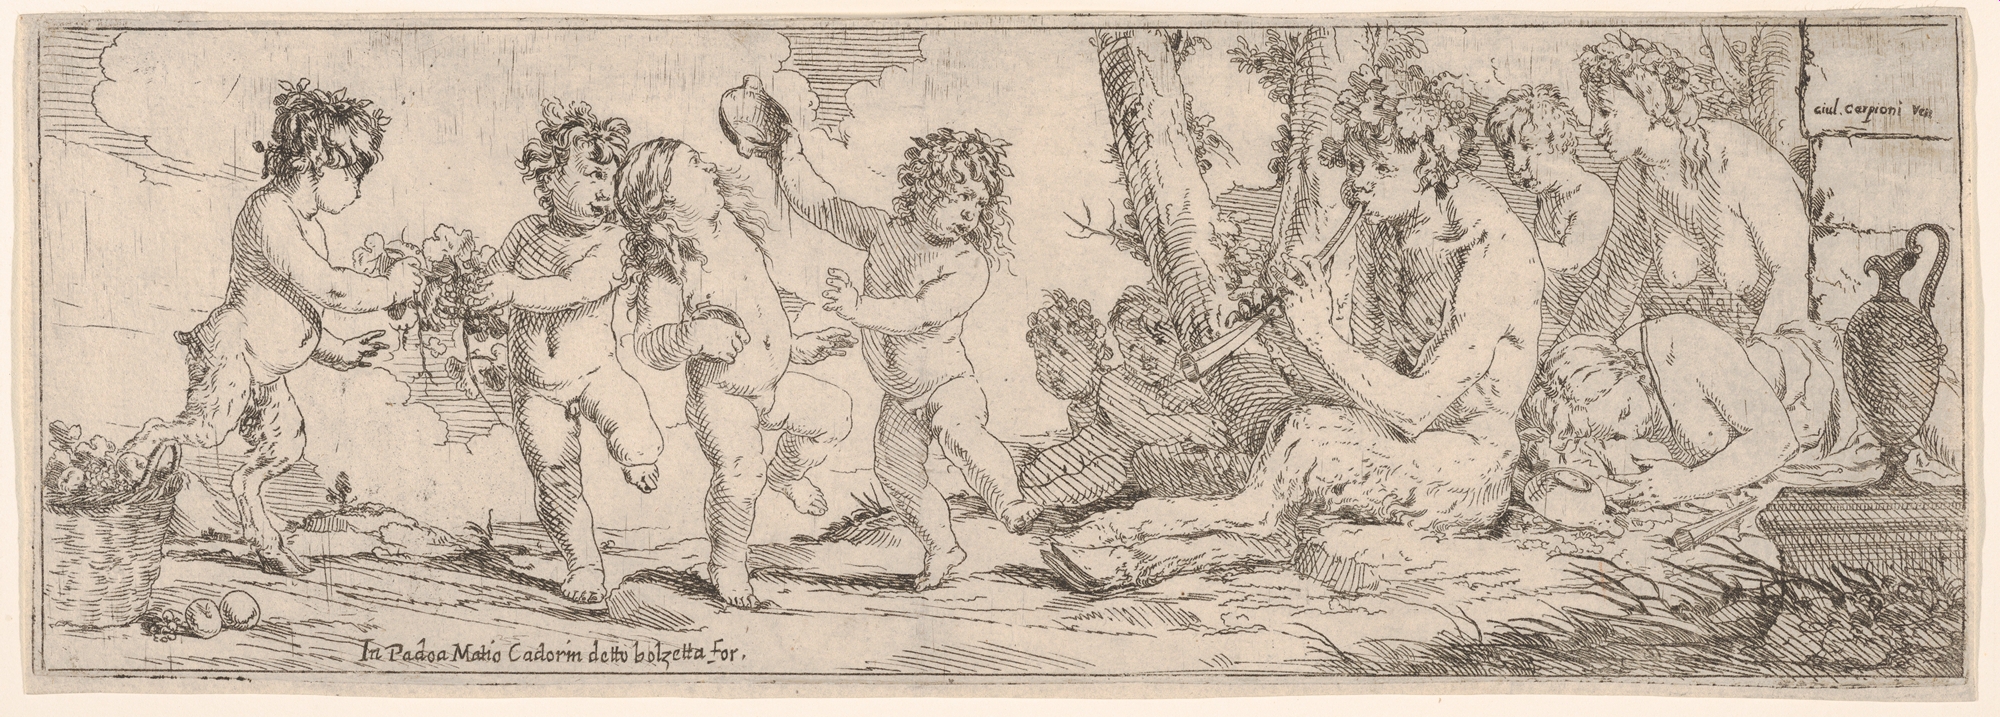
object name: print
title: Bacchanal with satyr playing a lute and surrounded by four figures, who look toward a succession of three putti and a satyr dancing with cups and vines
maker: giulio carpioni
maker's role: artist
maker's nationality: italian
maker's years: 1613-1678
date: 1640-1660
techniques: etching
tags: dancing,putti,satyrs,musicians